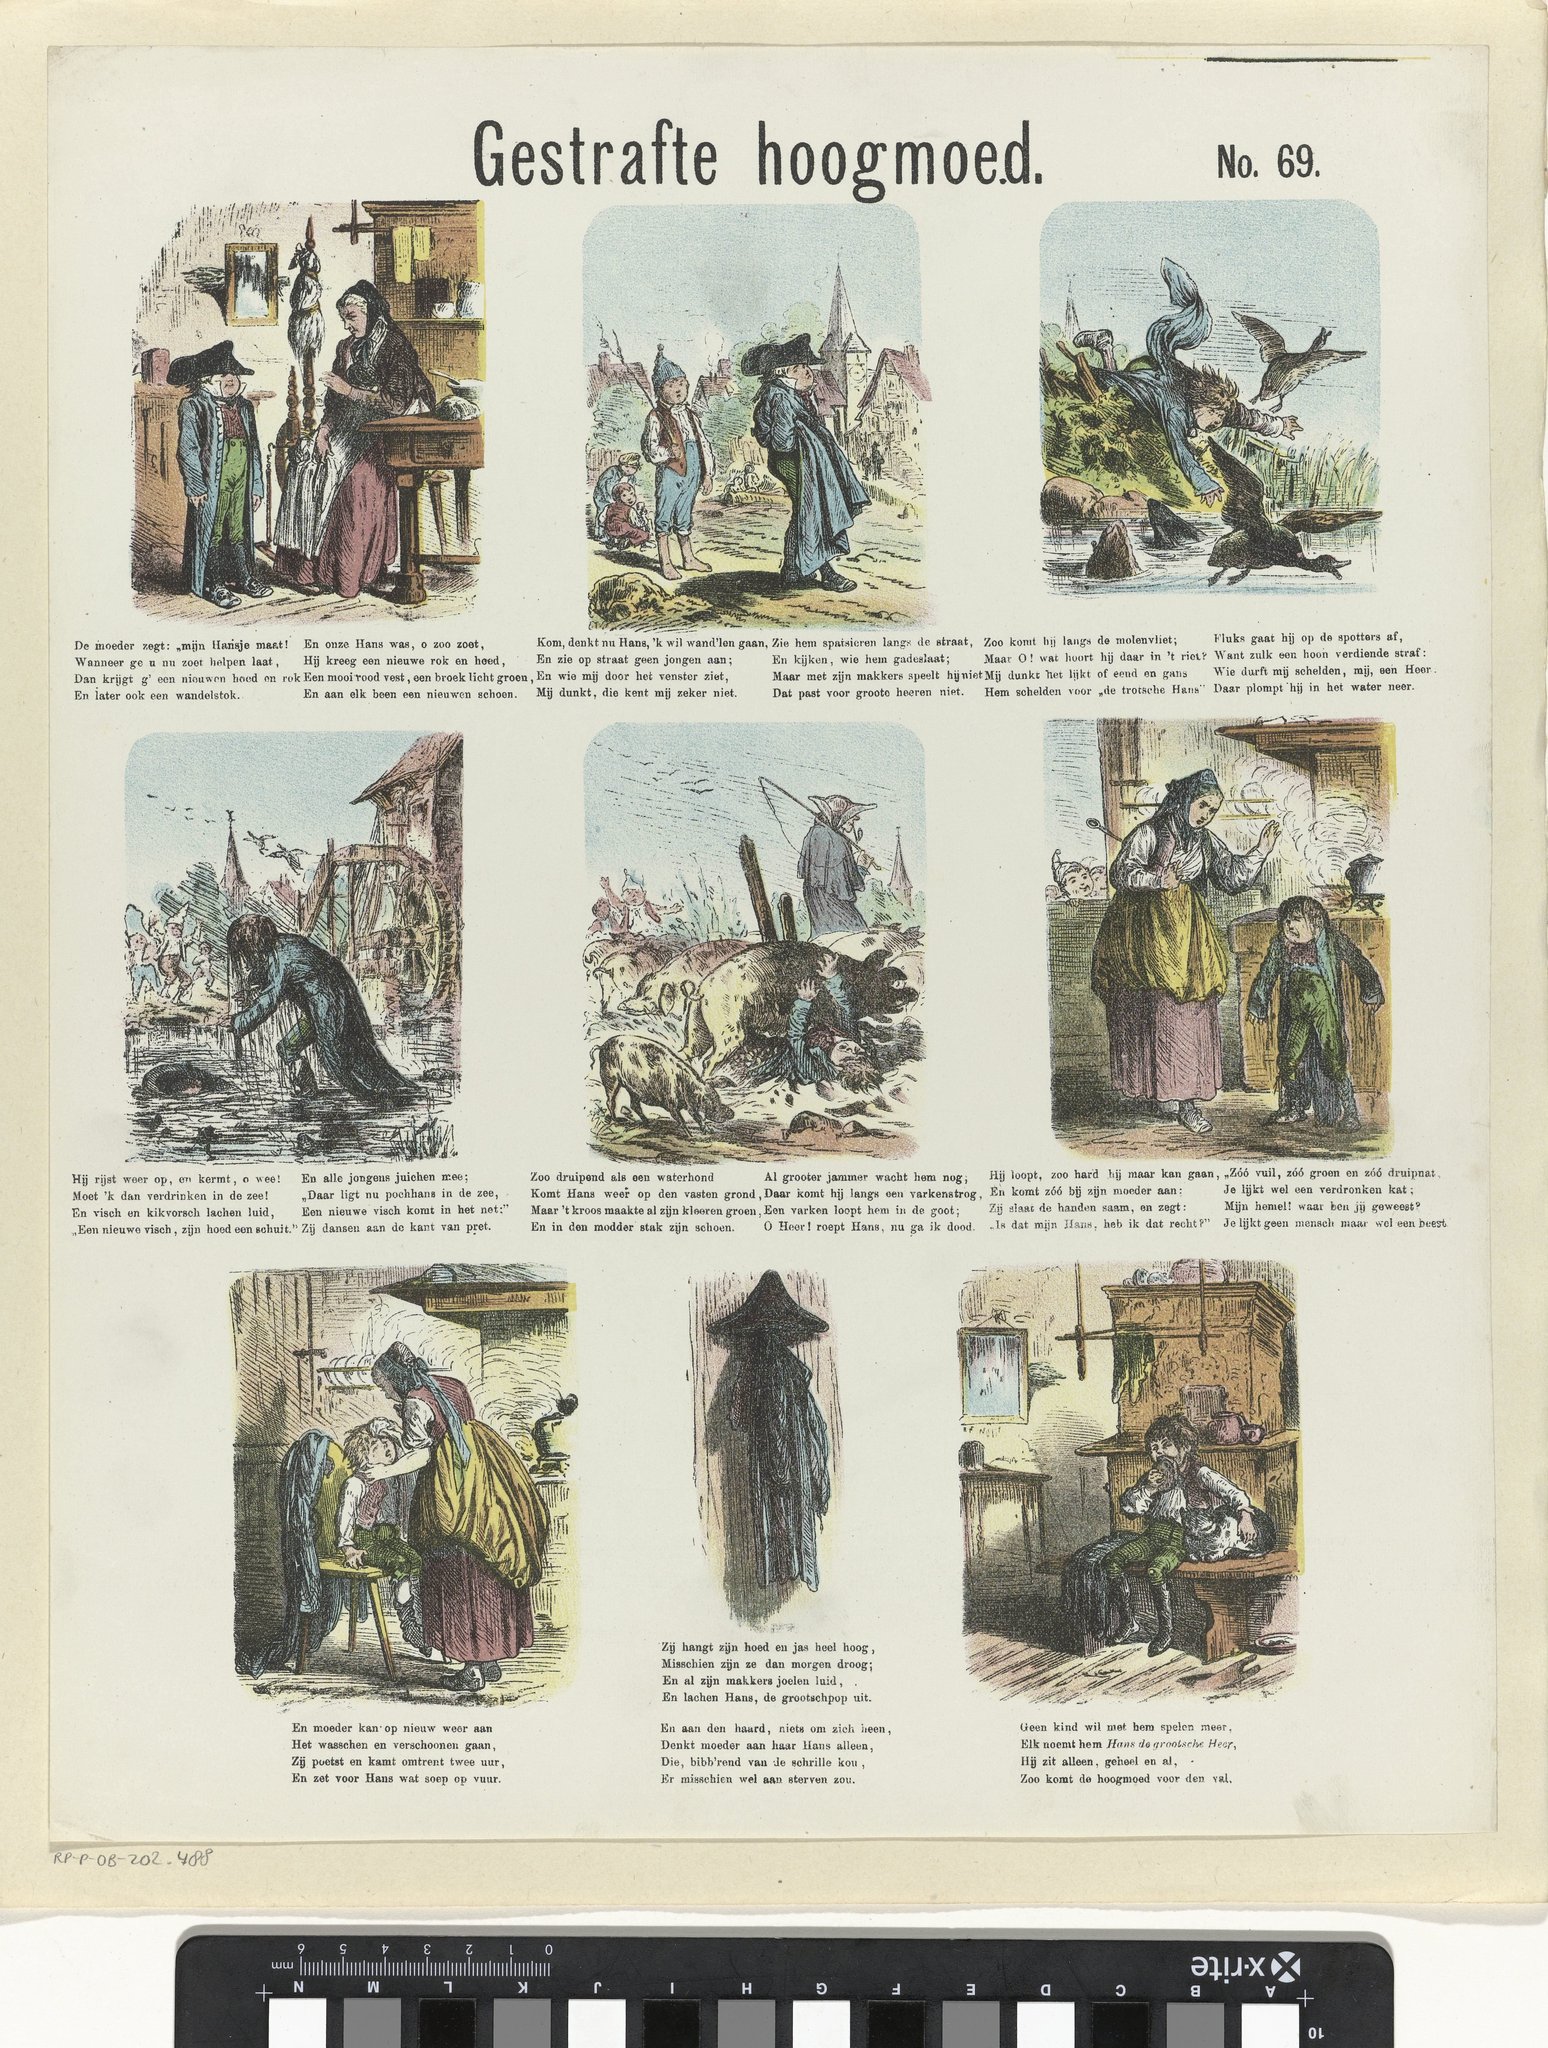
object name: print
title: Meijer's prenten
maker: Anonymous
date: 1878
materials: paper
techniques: lithograph, letterpress printing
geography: amsterdam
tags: mud (soil type), child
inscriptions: collector's mark: Lugt 2760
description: Blad met 9 voorstellingen over Hansje en zijn nieuwe kleren. Hans wandelt, valt in het water, valt bij de varkens, loopt smerig naar huis, wordt gewassen en zit eenzaam thuis omdat niemand meer met hem wil spelen. Onder elke voorstelling een onderschrift. Genummerd rechtsboven: No. 69.